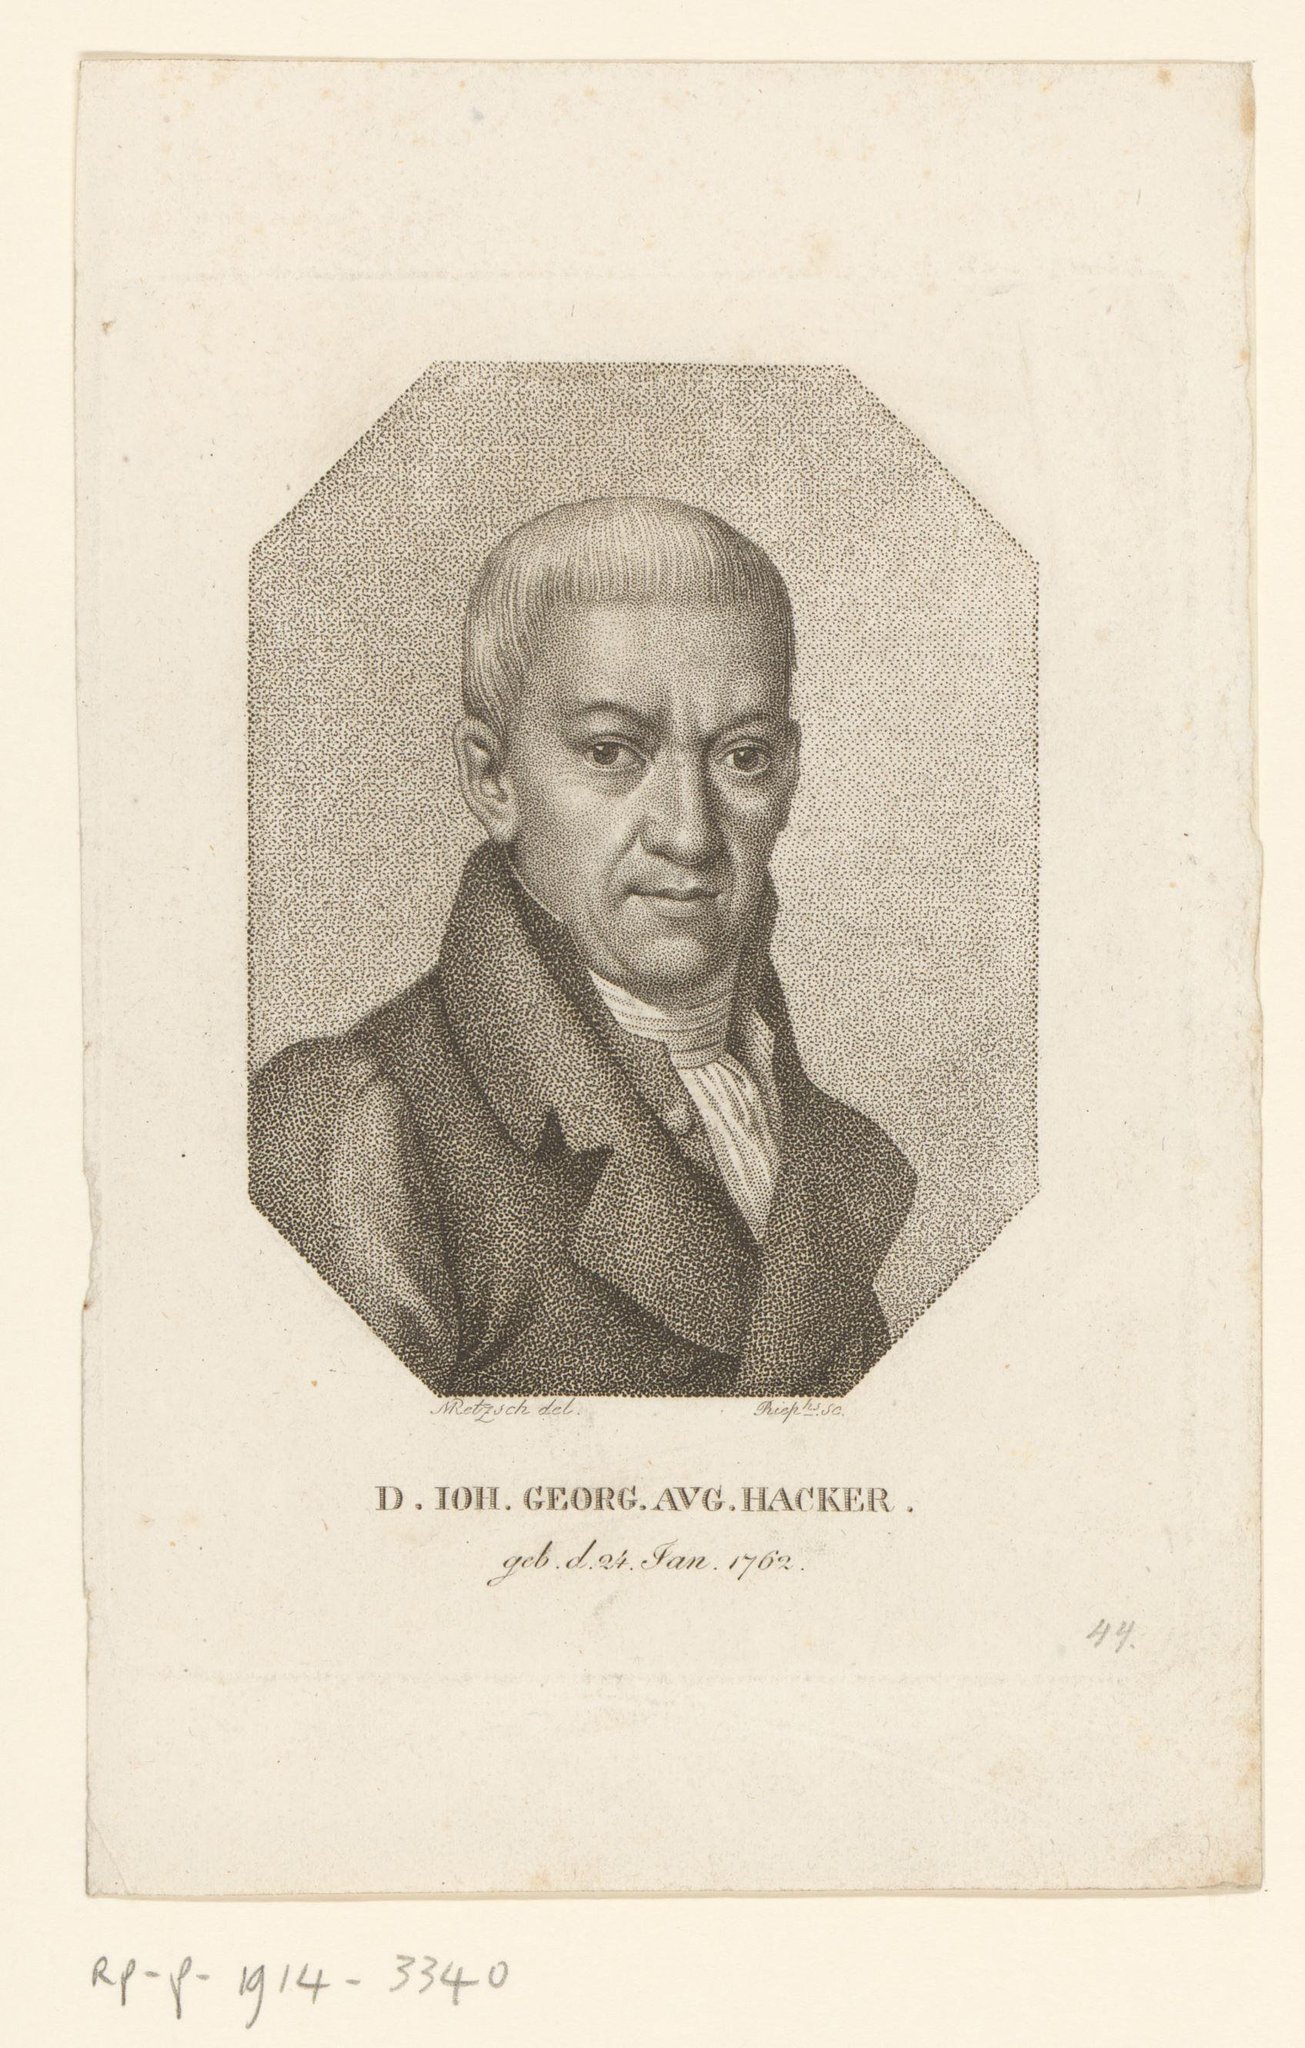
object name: print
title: Portret van Johann Georg August Hacker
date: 1775-1840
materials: paper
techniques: engraving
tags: theologian, historical persons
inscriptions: collector's mark: Lugt 2228